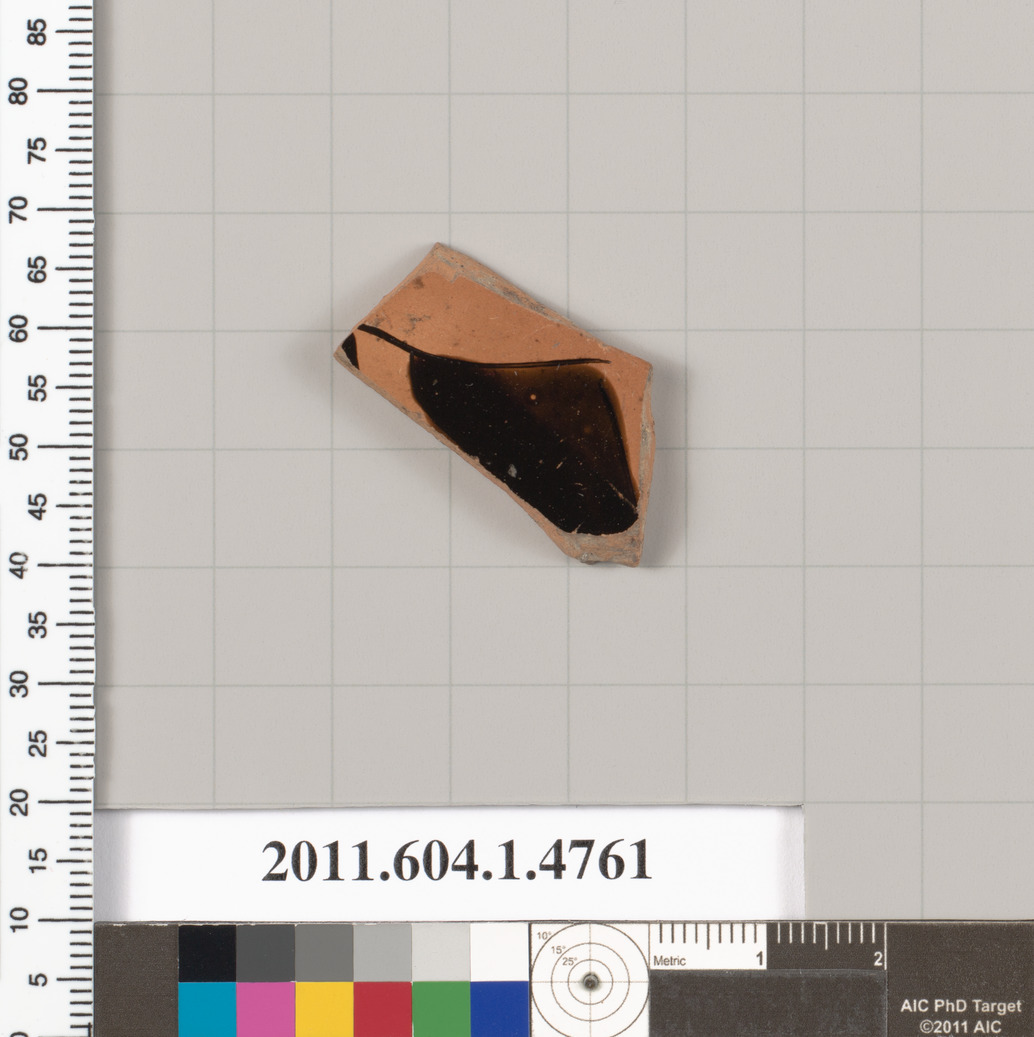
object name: kylix fragment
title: Terracotta fragment of a kylix (drinking cup)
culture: greek, attic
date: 490-480 BCE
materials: terracotta